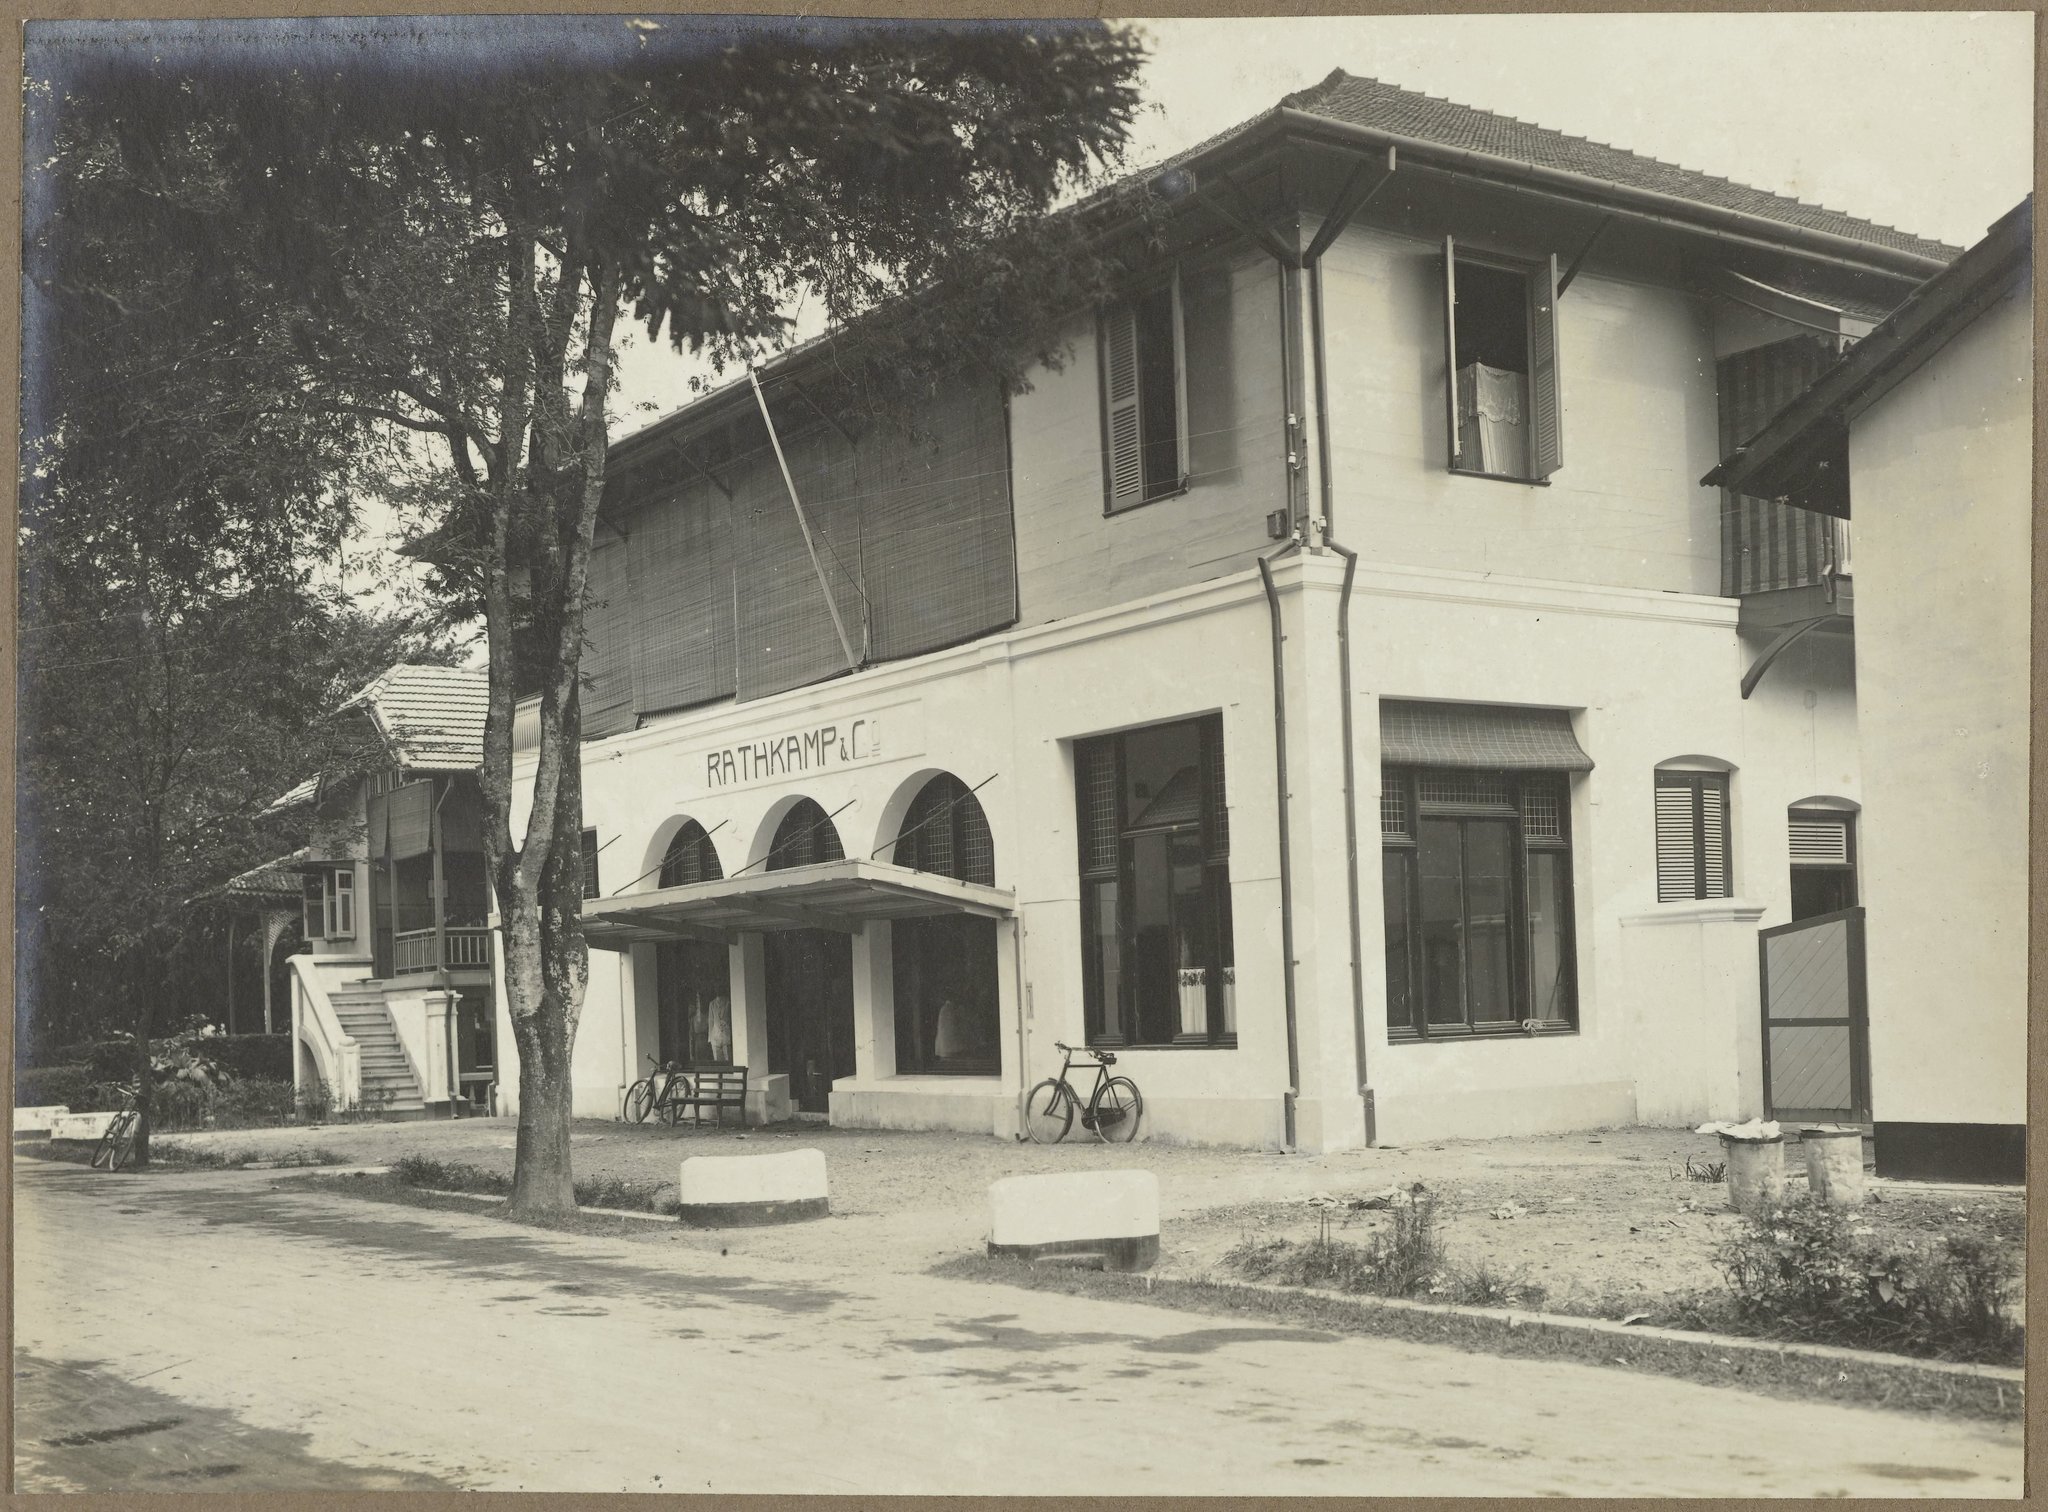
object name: photograph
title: Gebouw van Rathkamp & Co.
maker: Anonymous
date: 1914-1919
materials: photographic support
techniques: gelatin silver print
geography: medan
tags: representation of real building (either existing or having existed), architecture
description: Het gebouw van de apotheek Rathkamp & Co., waarschijnlijk te Medan. Foto in het fotoalbum van het Nederlandse architectenbureau en aannemersbedrijf Bennink en Riphagen te Medan in de jaren ca. 1914-1919.